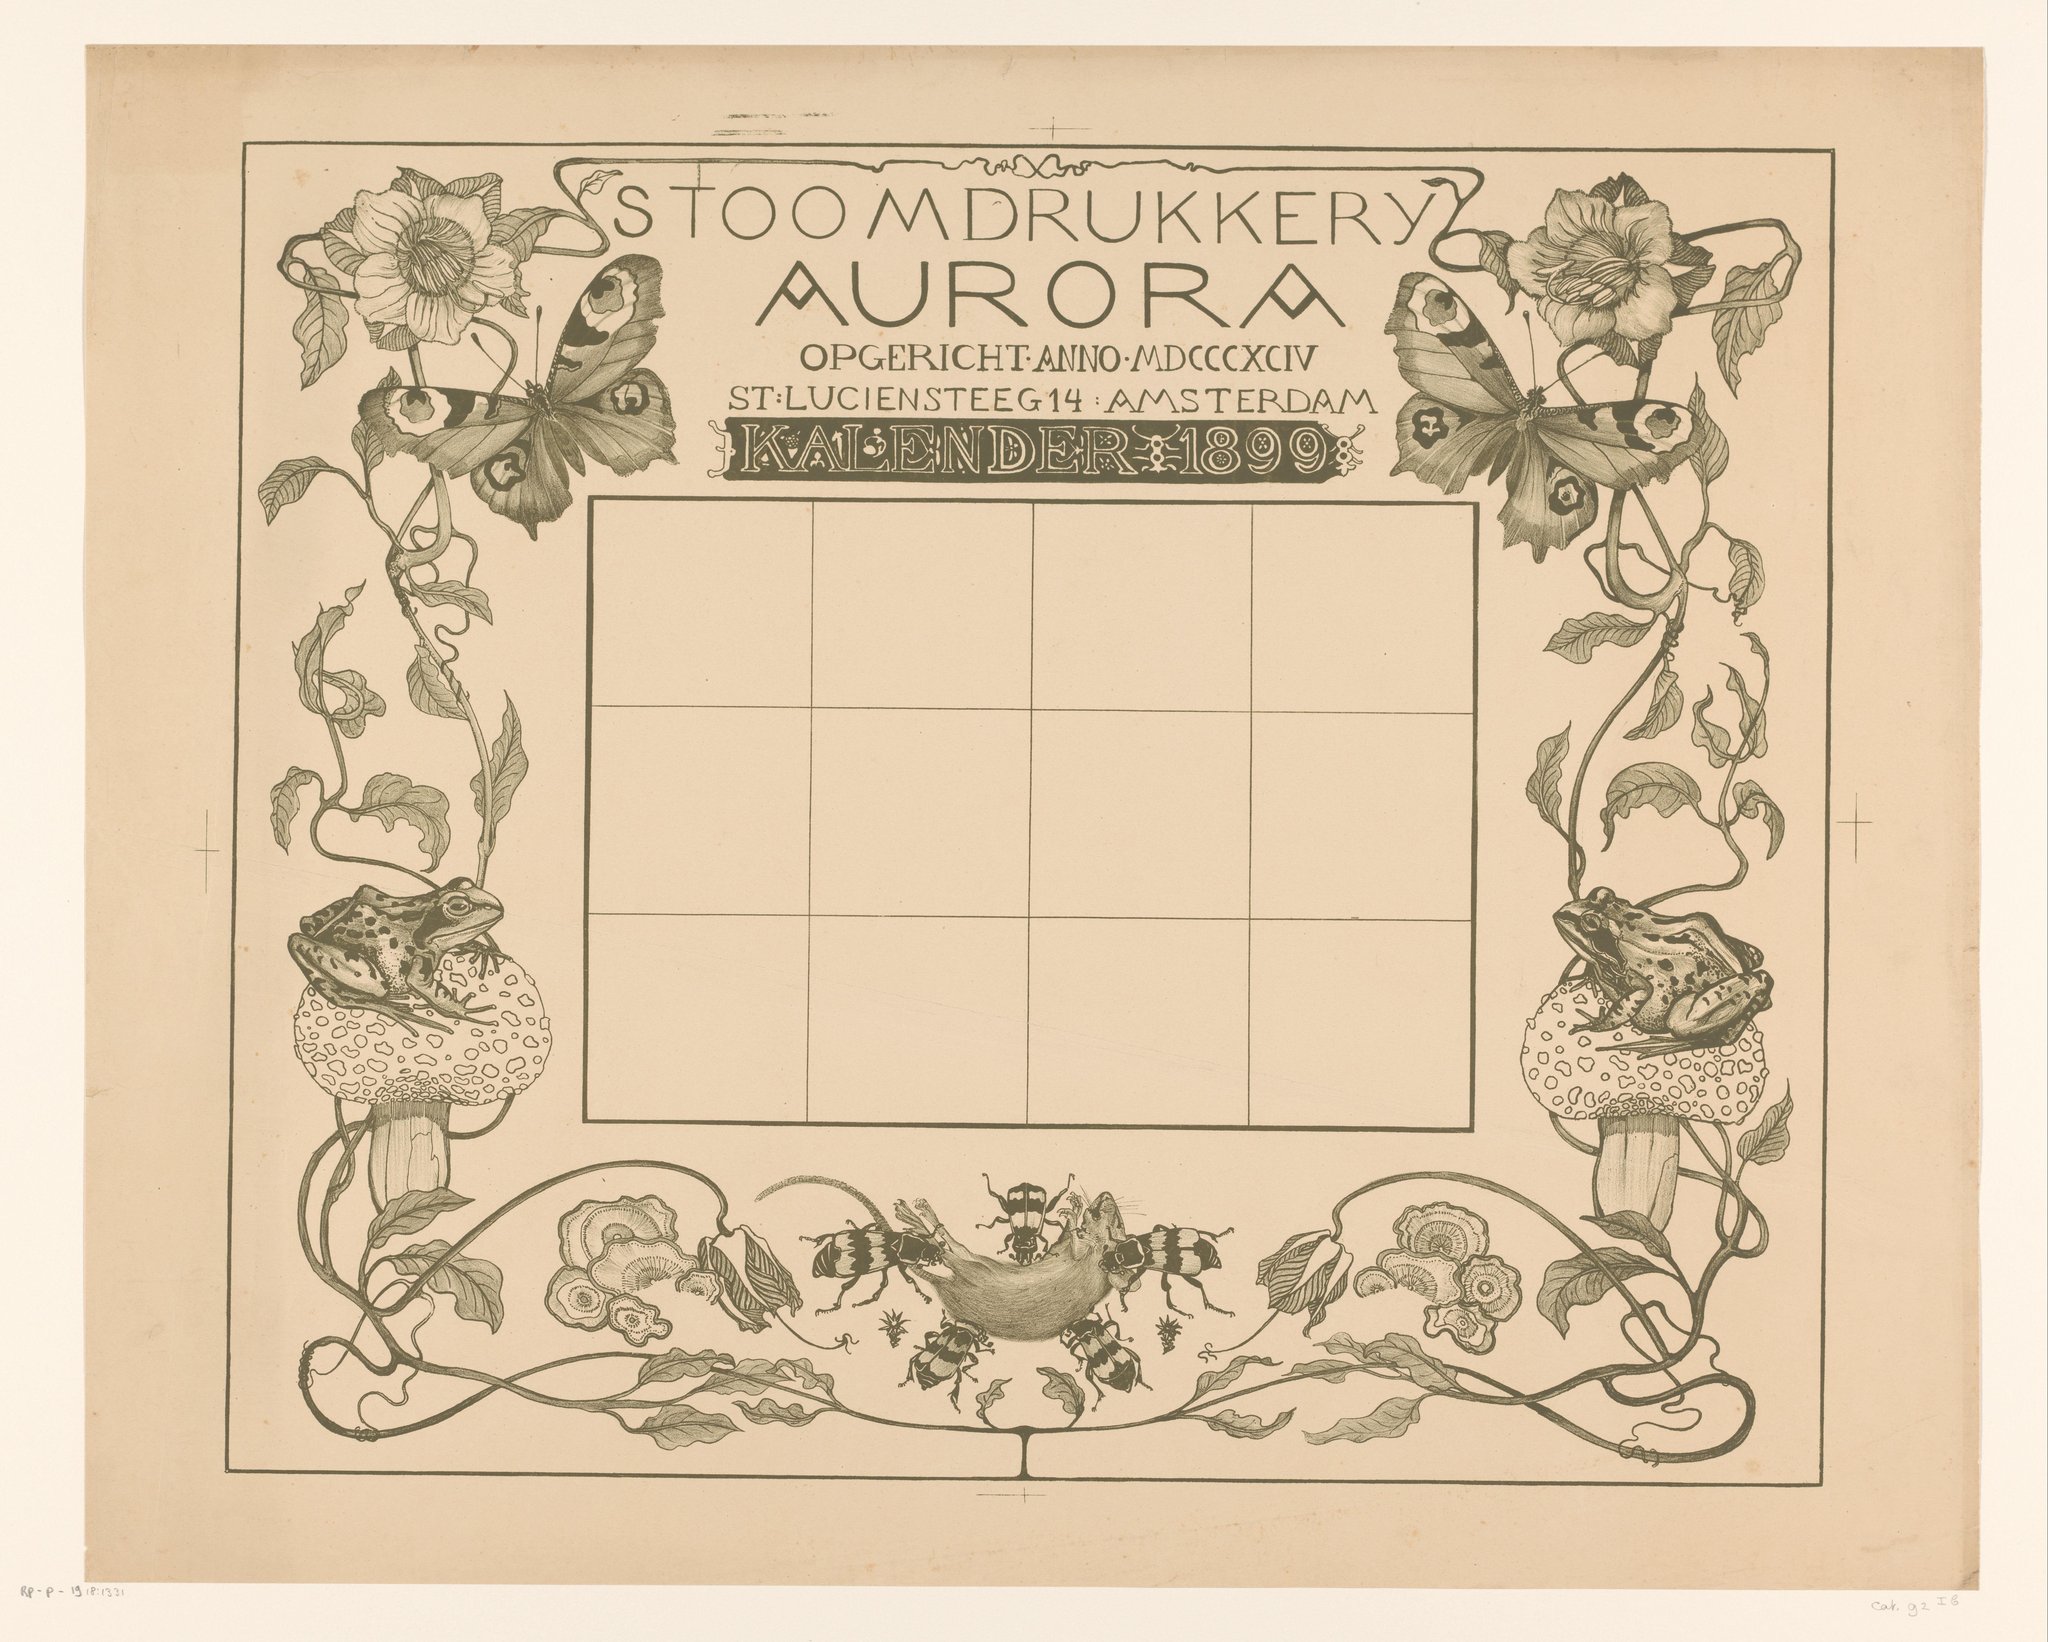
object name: calendar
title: Kalender van het jaar 1899, met bloemen, insecten en kikkers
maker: theo van hoytema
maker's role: draughtsman, painter, print maker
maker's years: 1863-1917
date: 1898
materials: paper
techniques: lithograph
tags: flowers, tailless amphibians: frog, calendar, almanac, insects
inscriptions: collector's mark: Lugt 2233